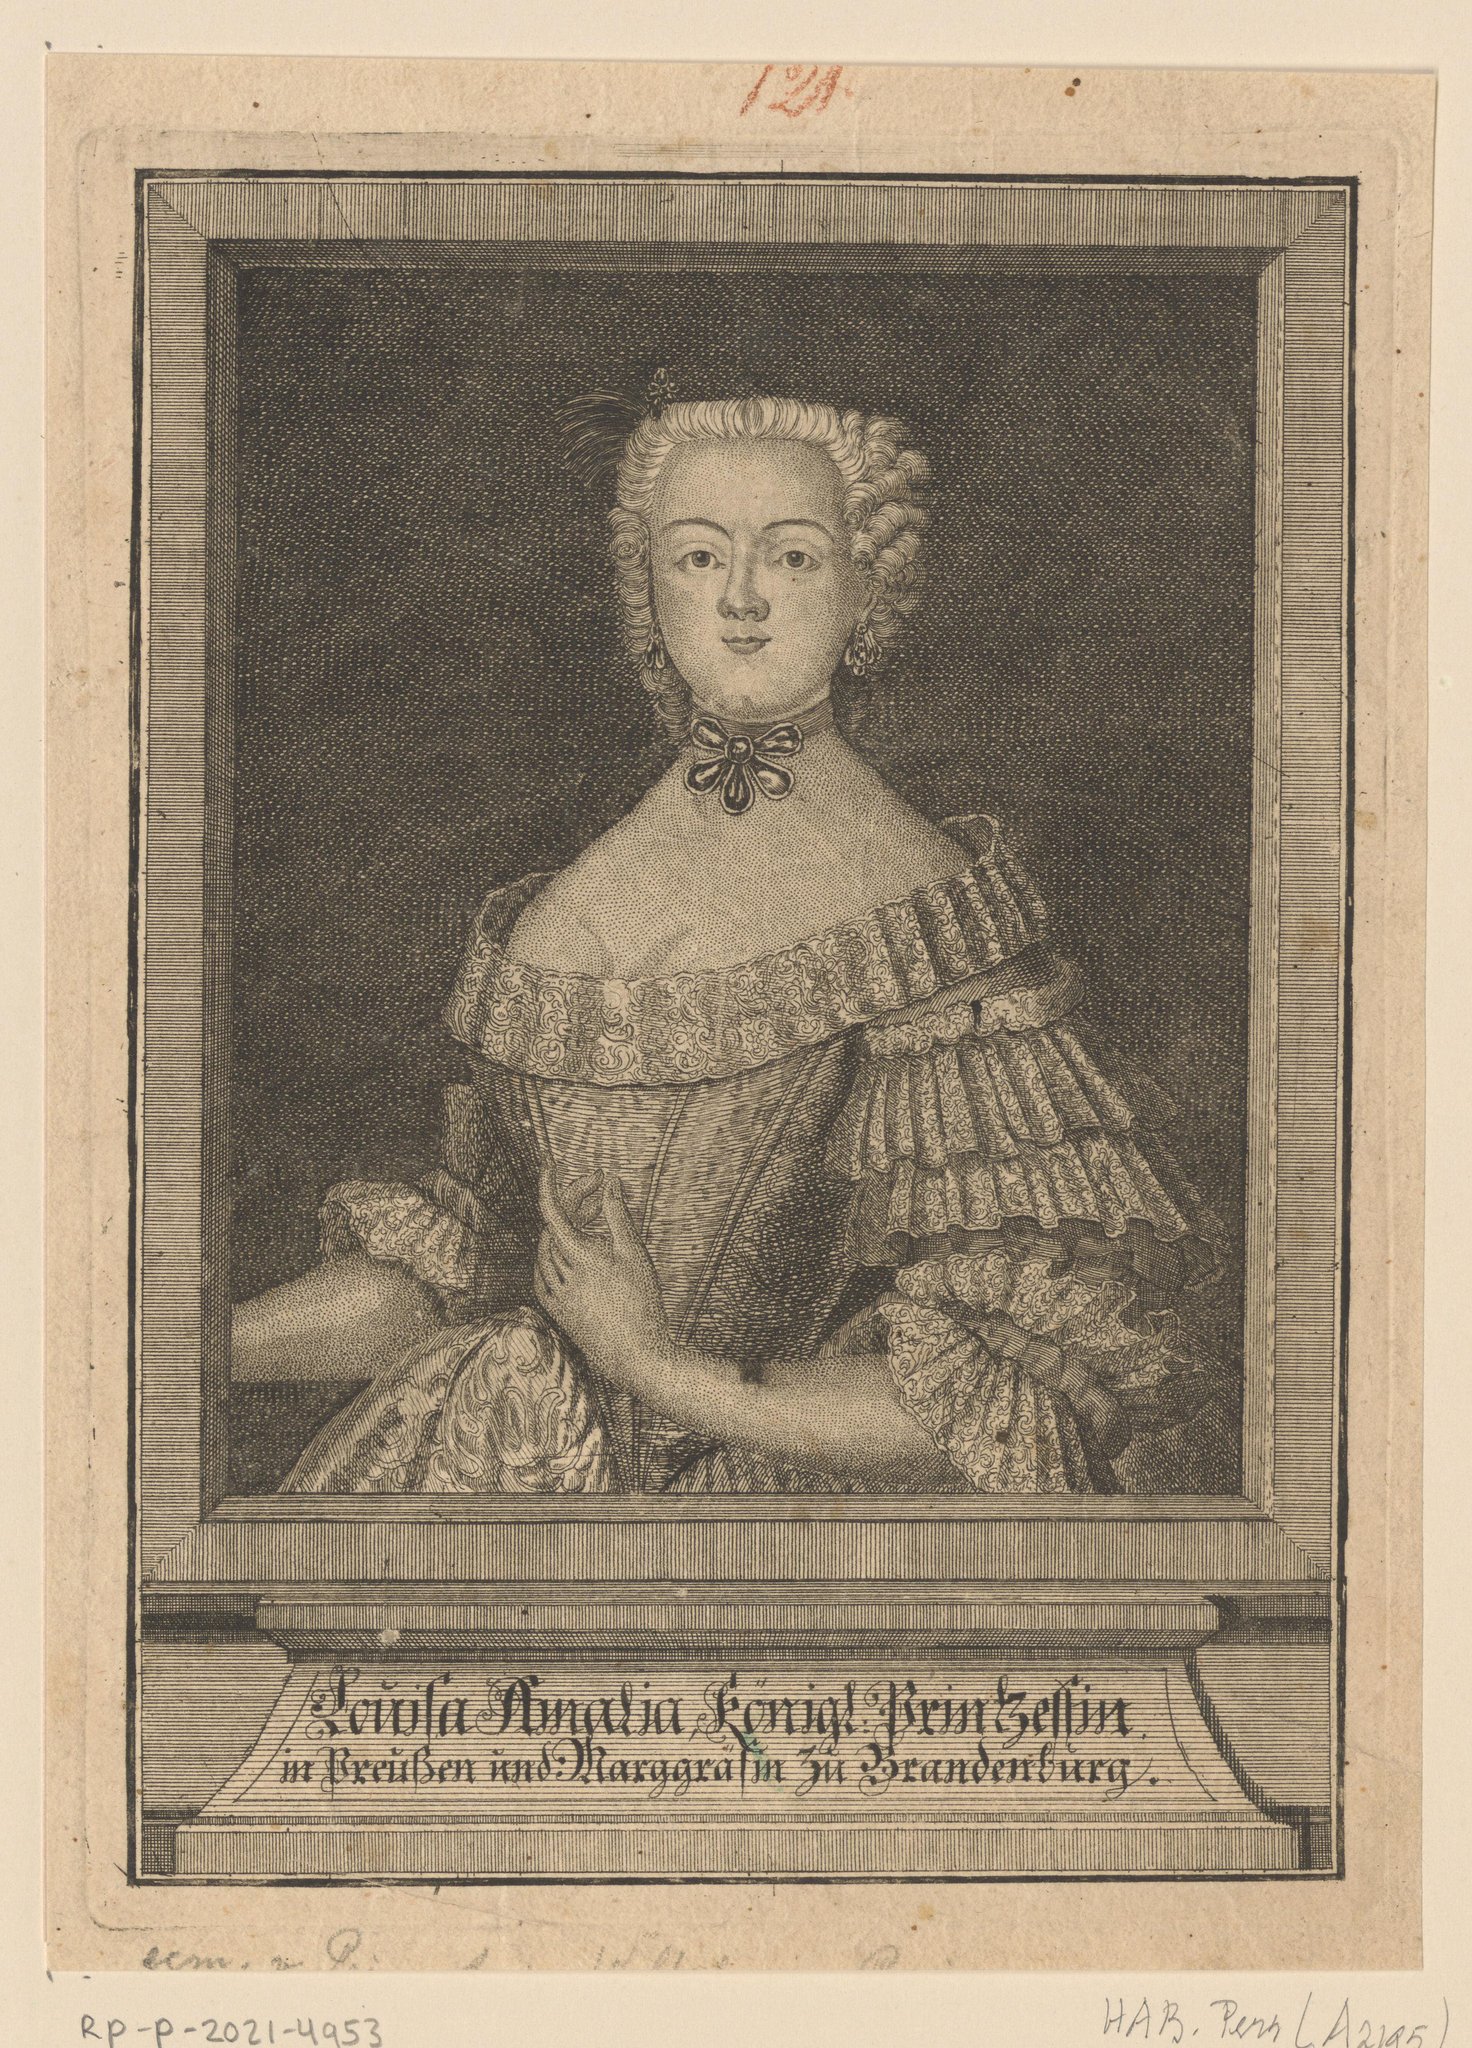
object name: print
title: Portret van Amalia van Brunswijk-Wolfenbüttel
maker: Anonymous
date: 1742-1780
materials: paper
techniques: etching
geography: germany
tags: historical persons - bb - woman